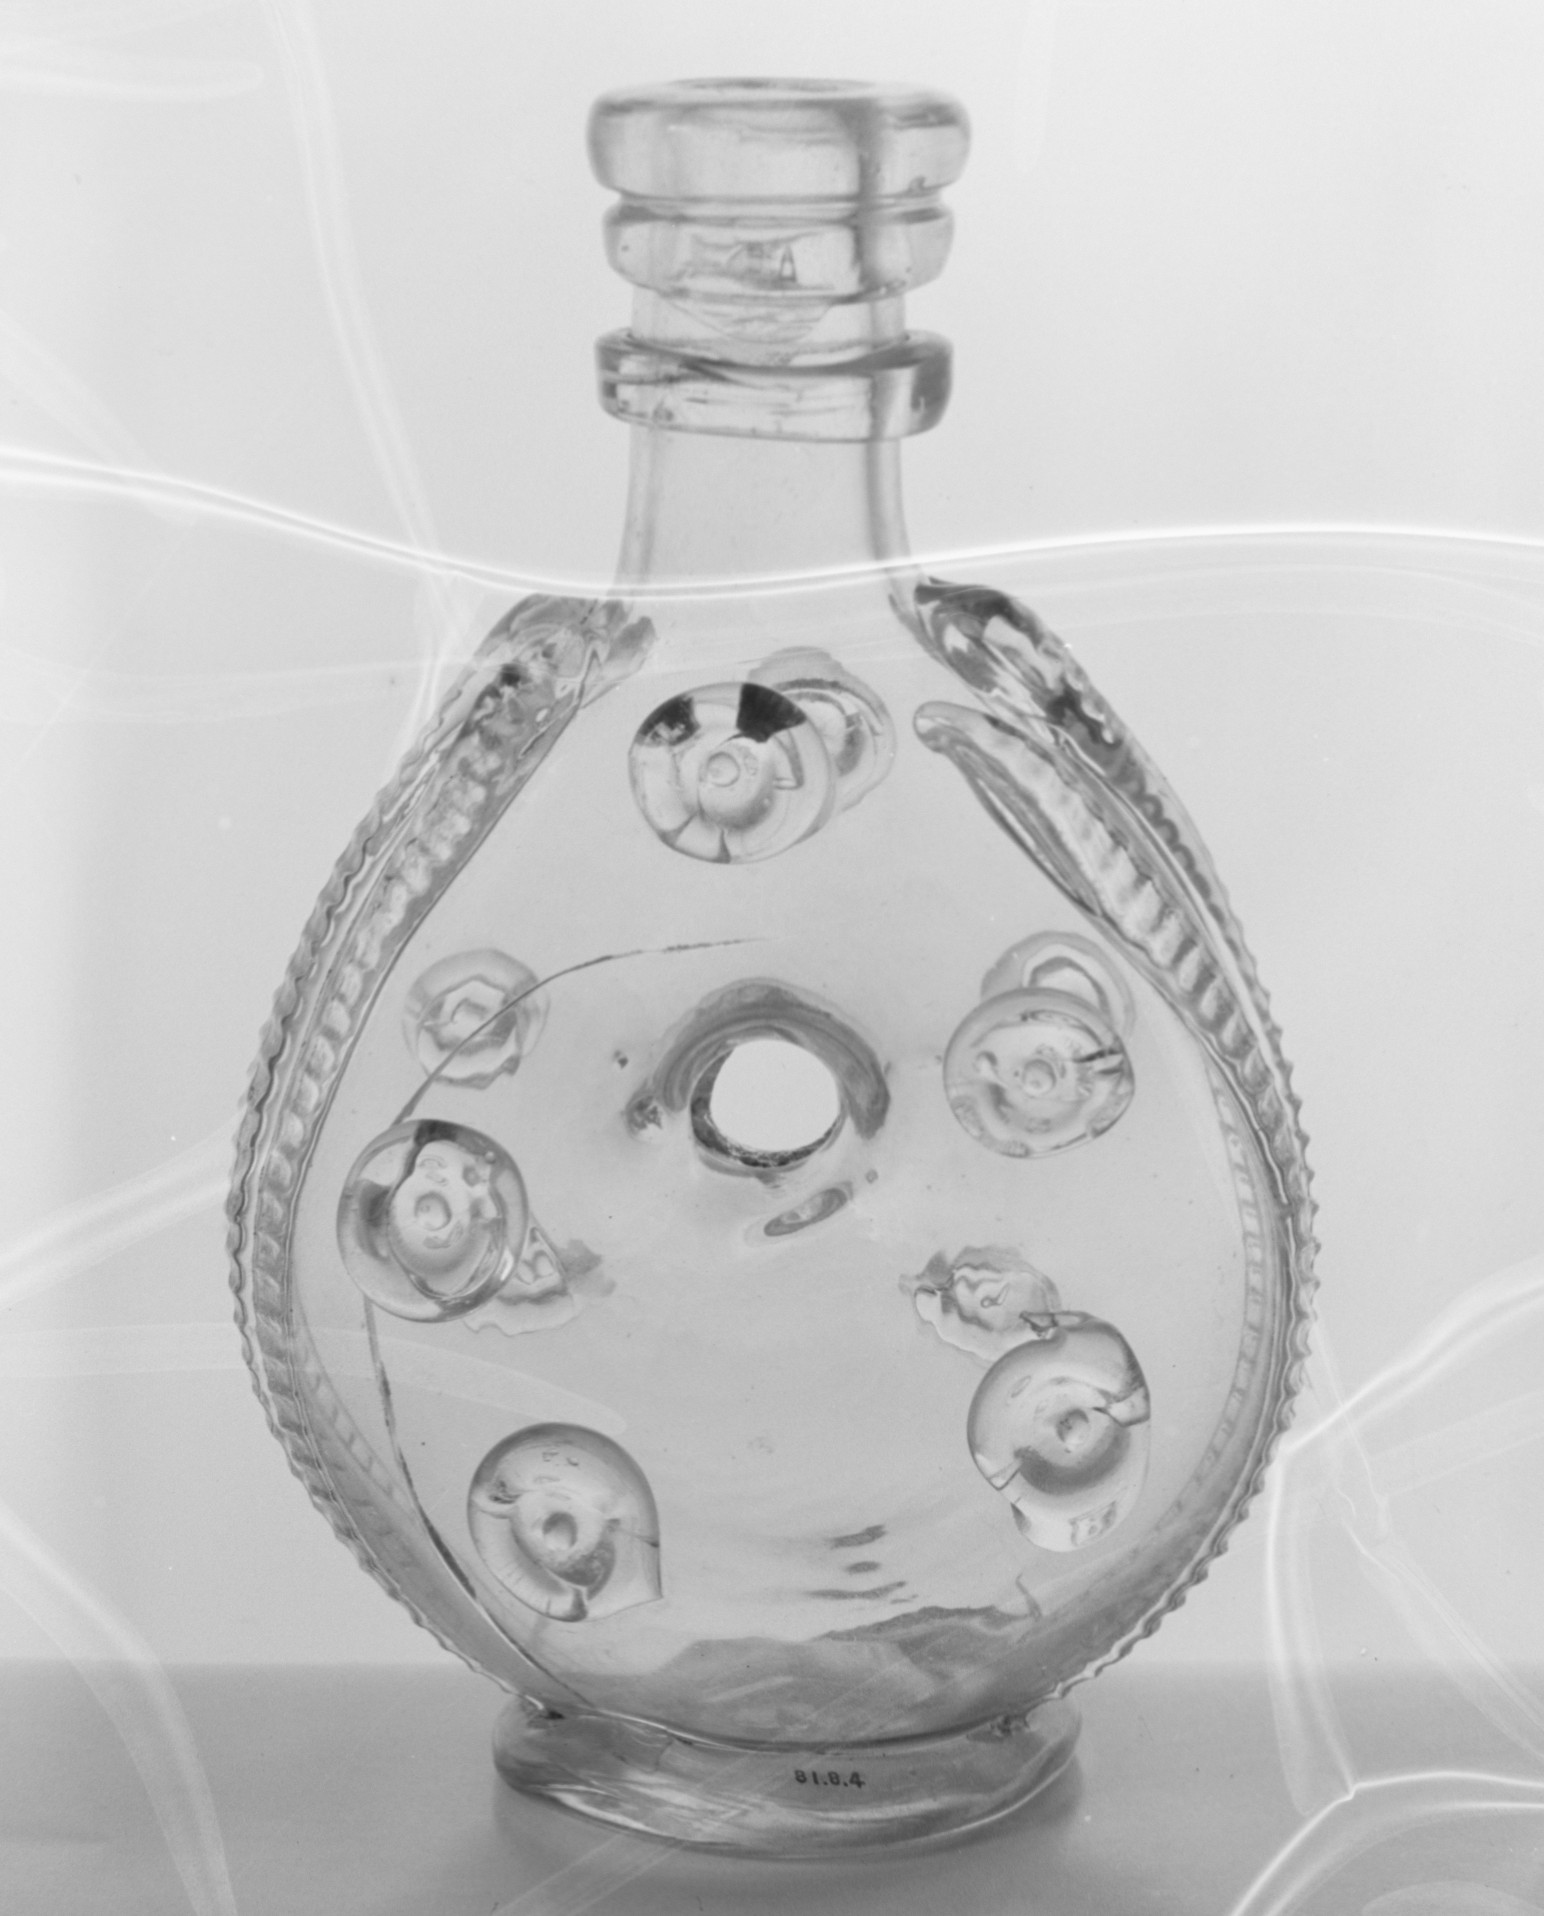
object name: bottle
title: Annular bottle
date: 1701-1733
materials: glass